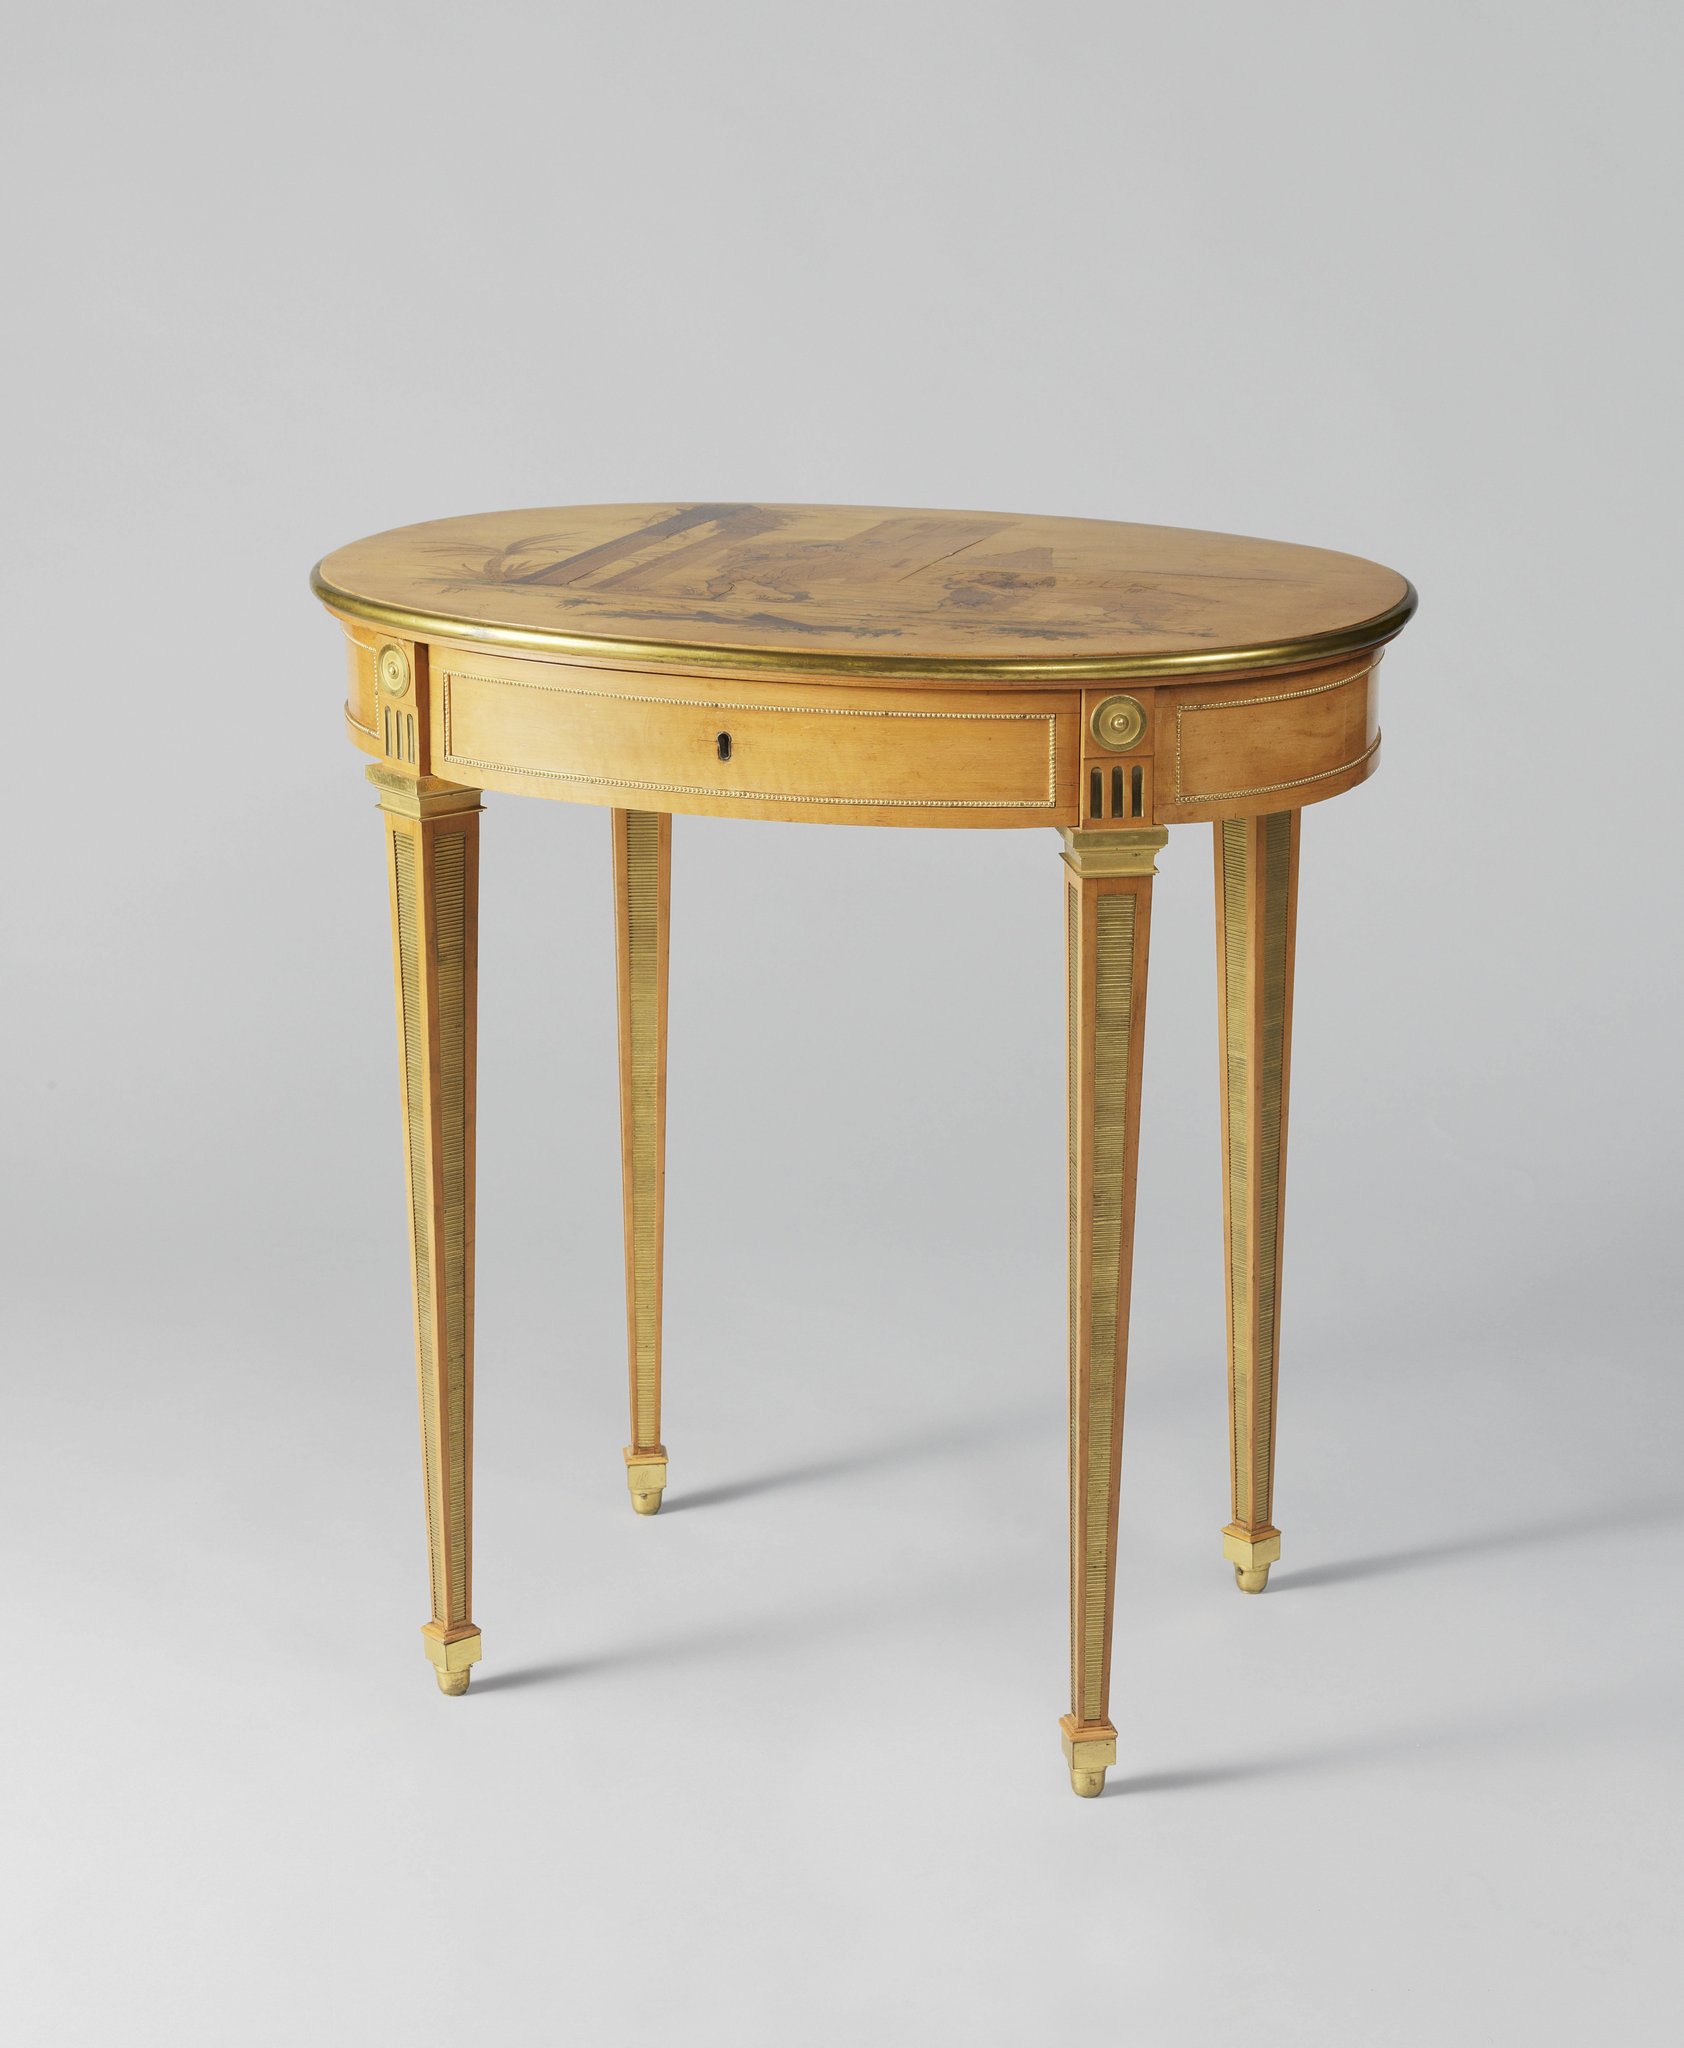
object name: table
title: Writing table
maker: david roentgen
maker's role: furniture worker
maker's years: 1743-1807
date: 1780-1785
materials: bronze, wood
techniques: gilding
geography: neuwied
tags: 'pius aeneas': aeneas, leading ascanius, escapes from burning troy, carrying his father anchises with the penates; his wife creusa, who sets out with them, is lost on the way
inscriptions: mark: ‘22’, mark: ‘23’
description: Roentgen was renowned for his marquetry, which is composed, like a jigsaw puzzle, of tiny pieces of different wood, without engraved details. He called this technique à la mosaïque. On this tabletop the Greek hero Aeneas is shown fleeing the burning city of Troy carrying his father Anchises on his back. This story is recounted by the Roman poet Virgil in the Aeneid, an epic poem about Aeneas’ heroic deeds.